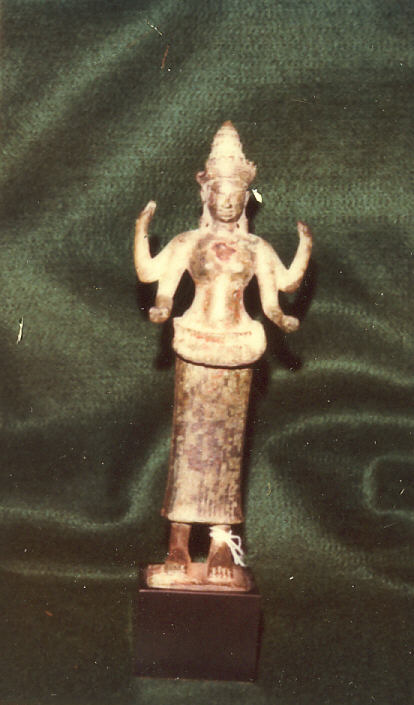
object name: figure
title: Standing Four-Armed Female Deity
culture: cambodian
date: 951-975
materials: bronze